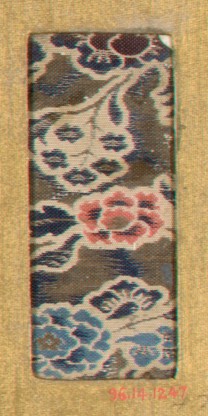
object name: piece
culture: japanese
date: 1701-1900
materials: silk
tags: flowers